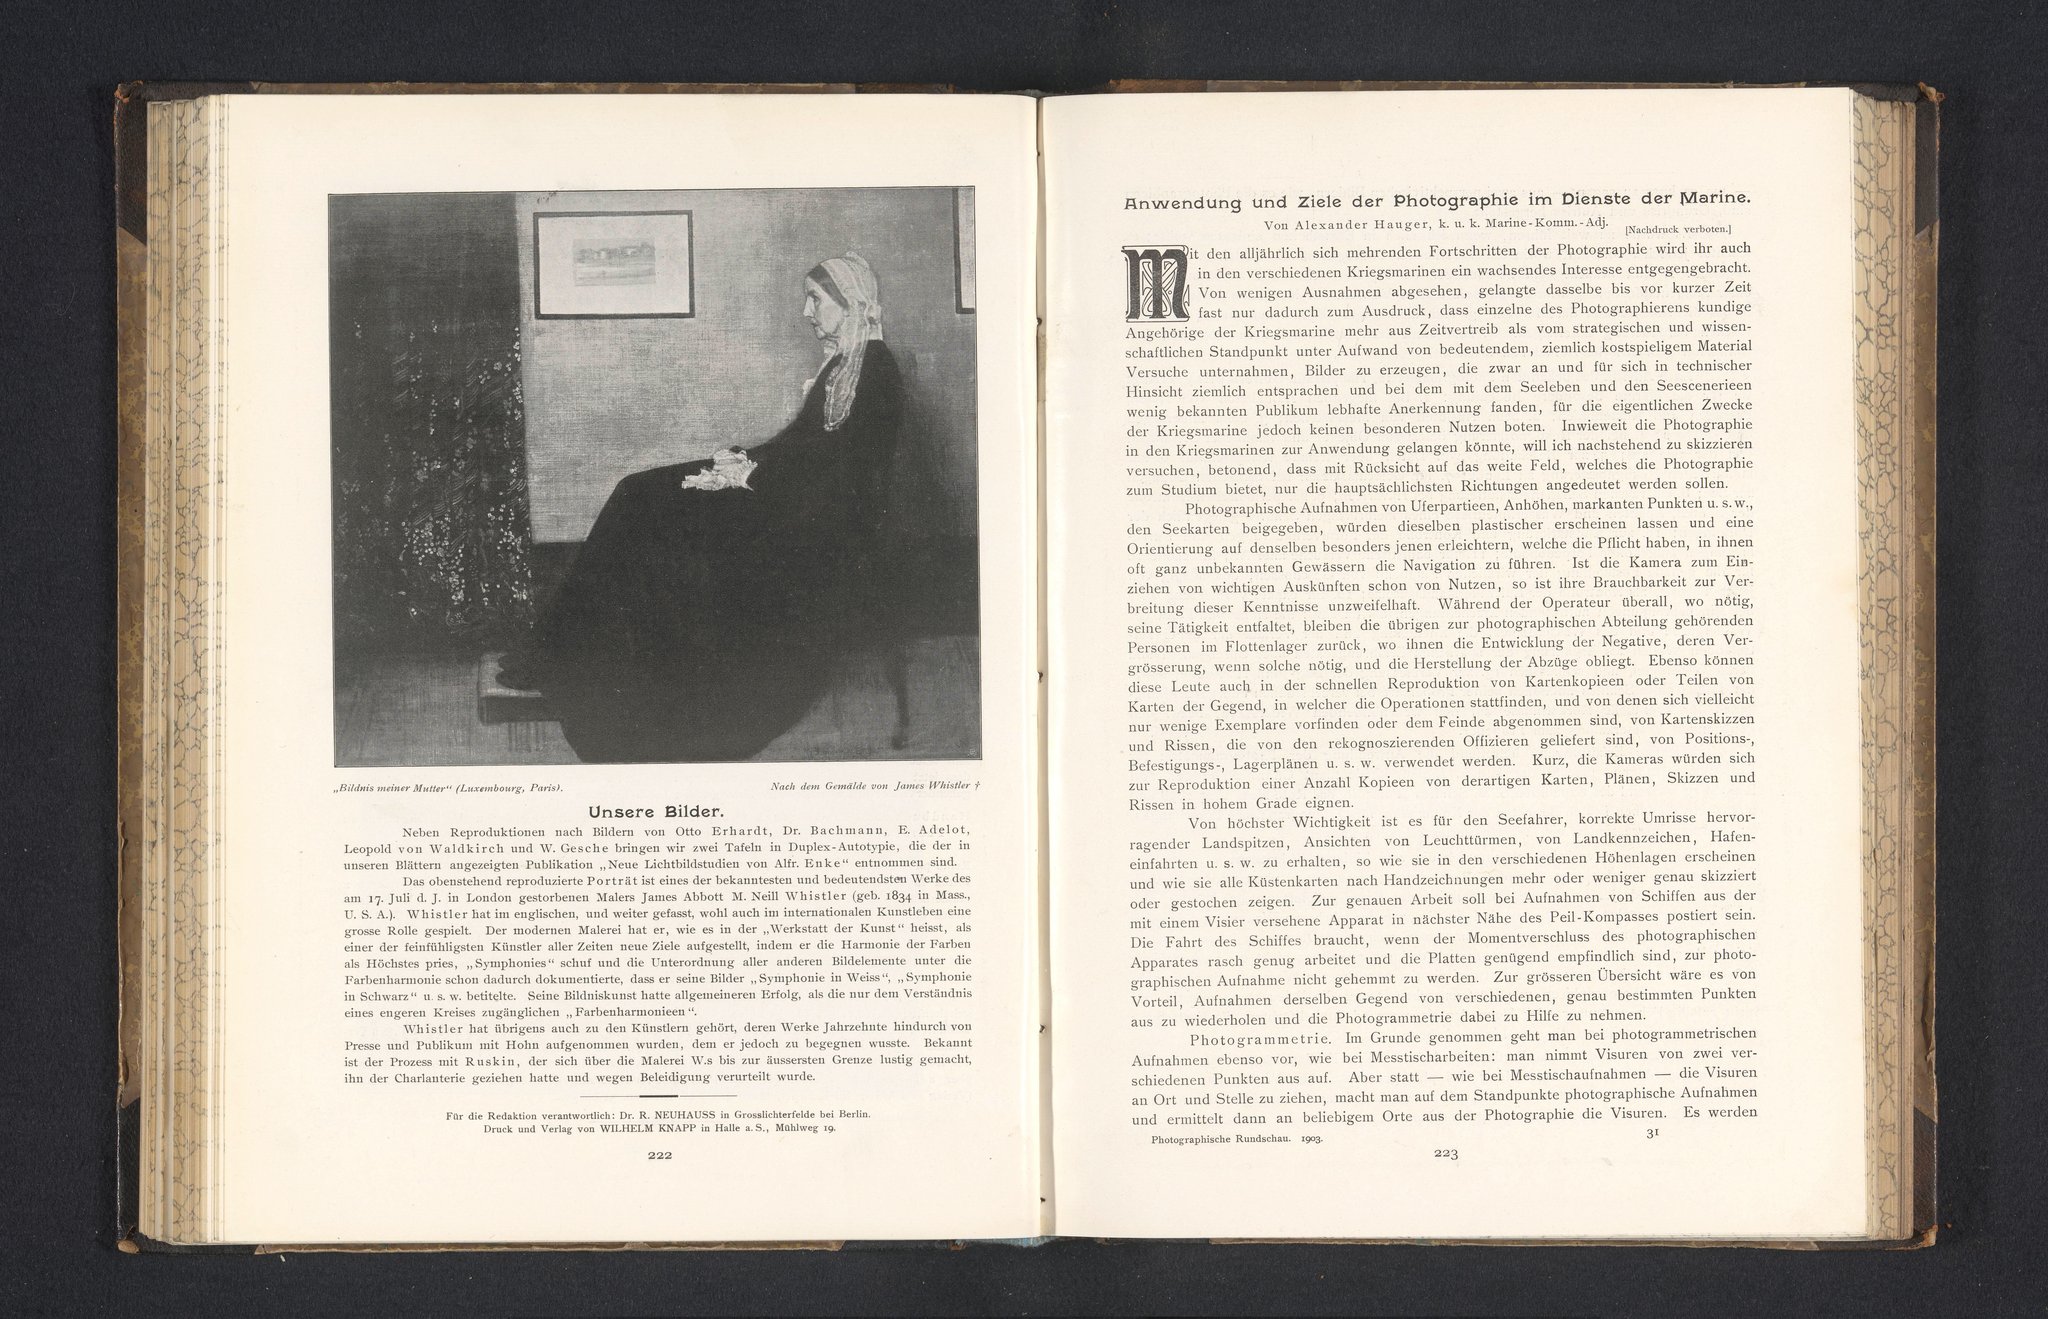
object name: photomechanical print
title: "Bildnis meiner Mutter" (Luxembourg, Paris)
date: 1898-1903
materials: paper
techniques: autotype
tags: historical persons - bb - woman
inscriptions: monogram: ‘AB/ M’